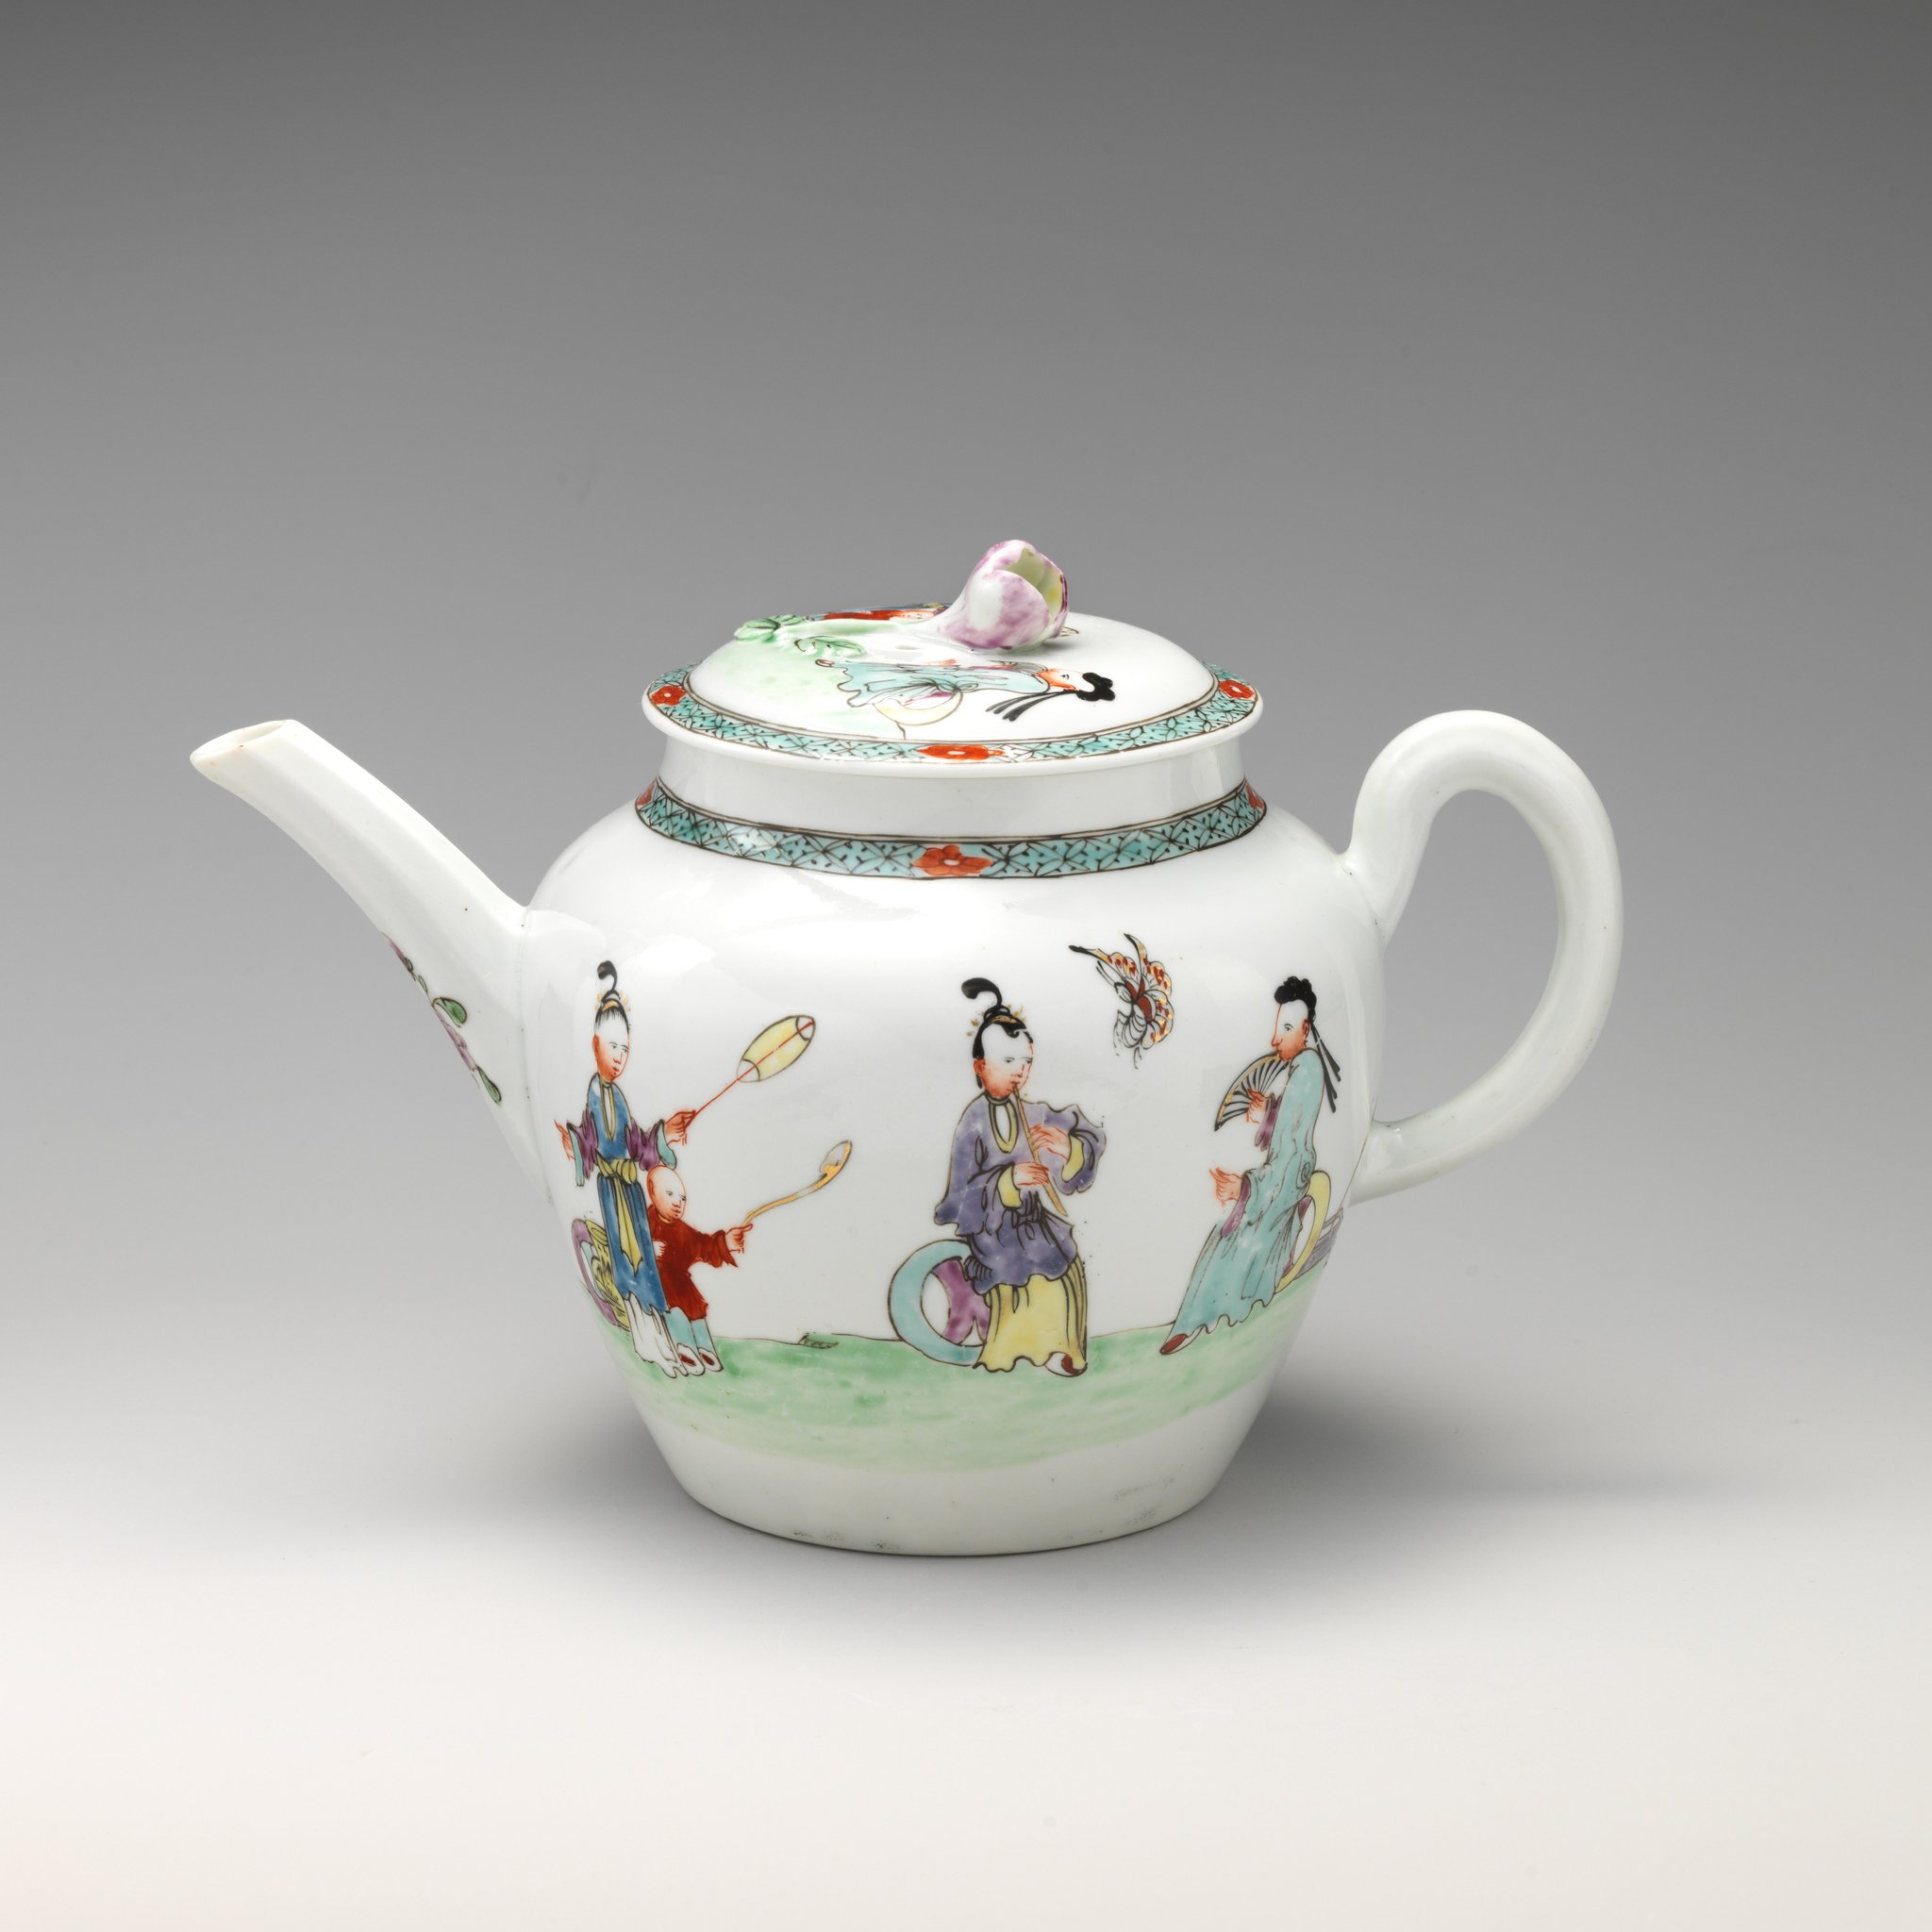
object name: teapot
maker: worcester factory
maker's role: factory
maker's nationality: british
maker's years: 1751-2008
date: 1768-1778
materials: enamel, soft paste porcelain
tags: chinoiserie,children,men,women